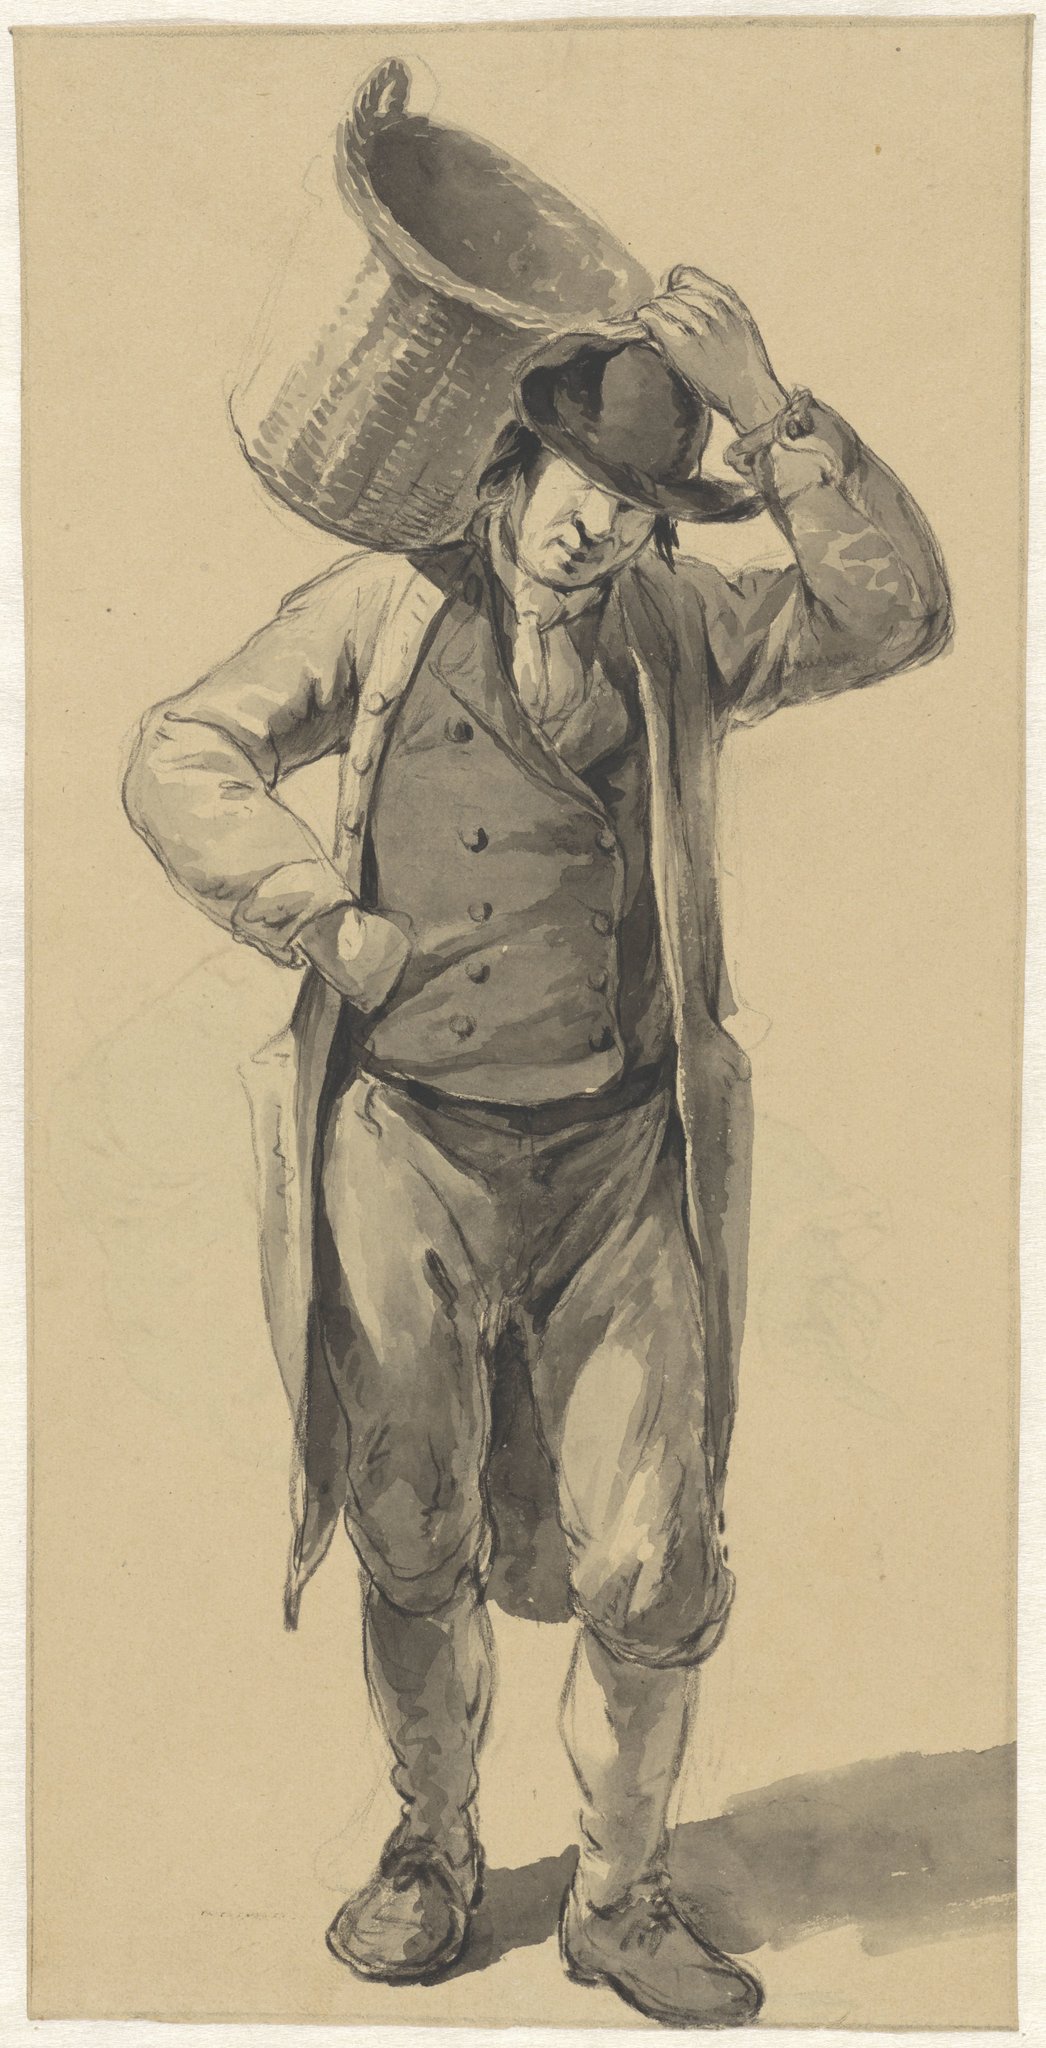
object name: drawing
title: Staande man met een mand op de schouder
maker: johannes christiaan schotel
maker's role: draughtsman, painter, print maker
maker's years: 1787-1838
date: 1797-1838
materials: chalk, paper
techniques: brush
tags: standing figure, container made of plant material other than wood: basket